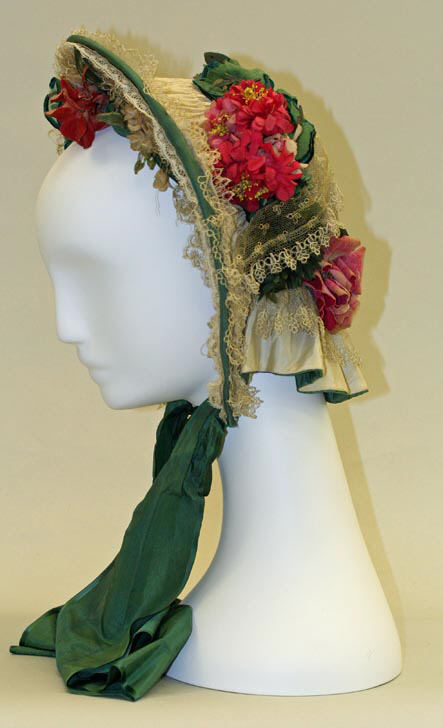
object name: bonnet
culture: american or european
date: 1860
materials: silk